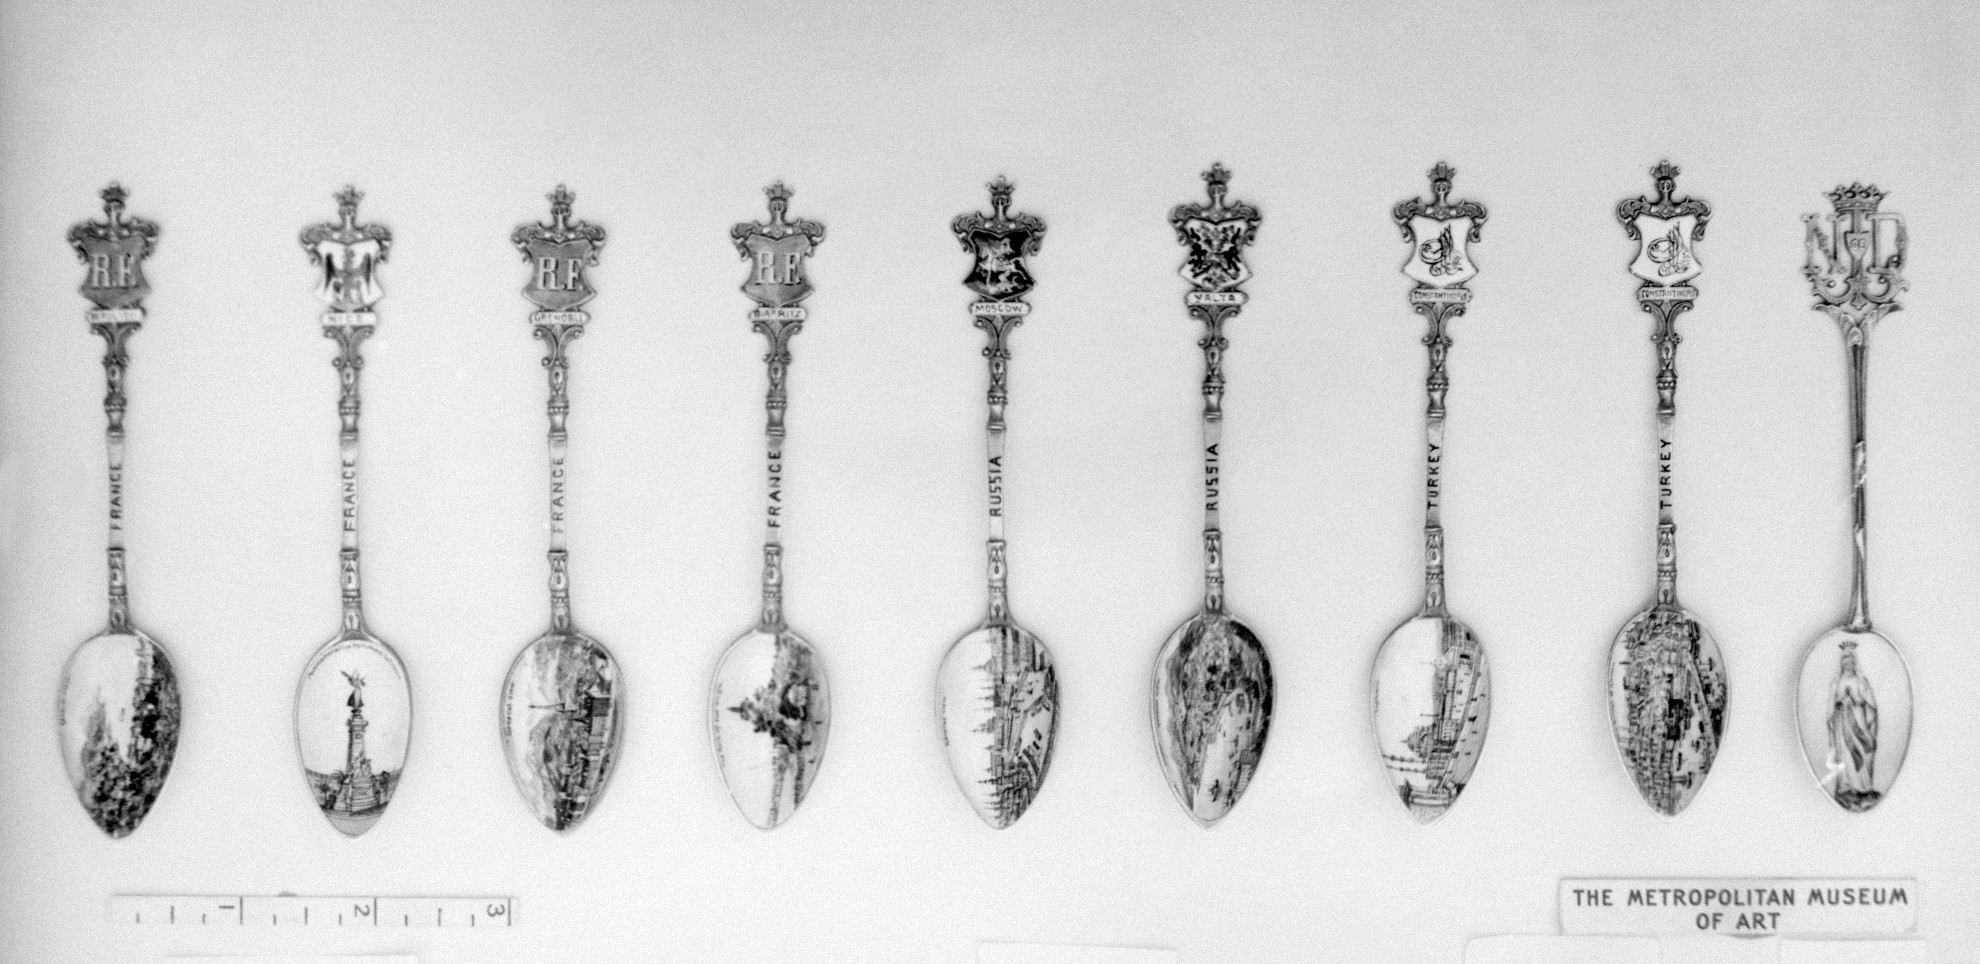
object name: souvenir spoon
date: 1867-1900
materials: enamel, gilt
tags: coat of arms